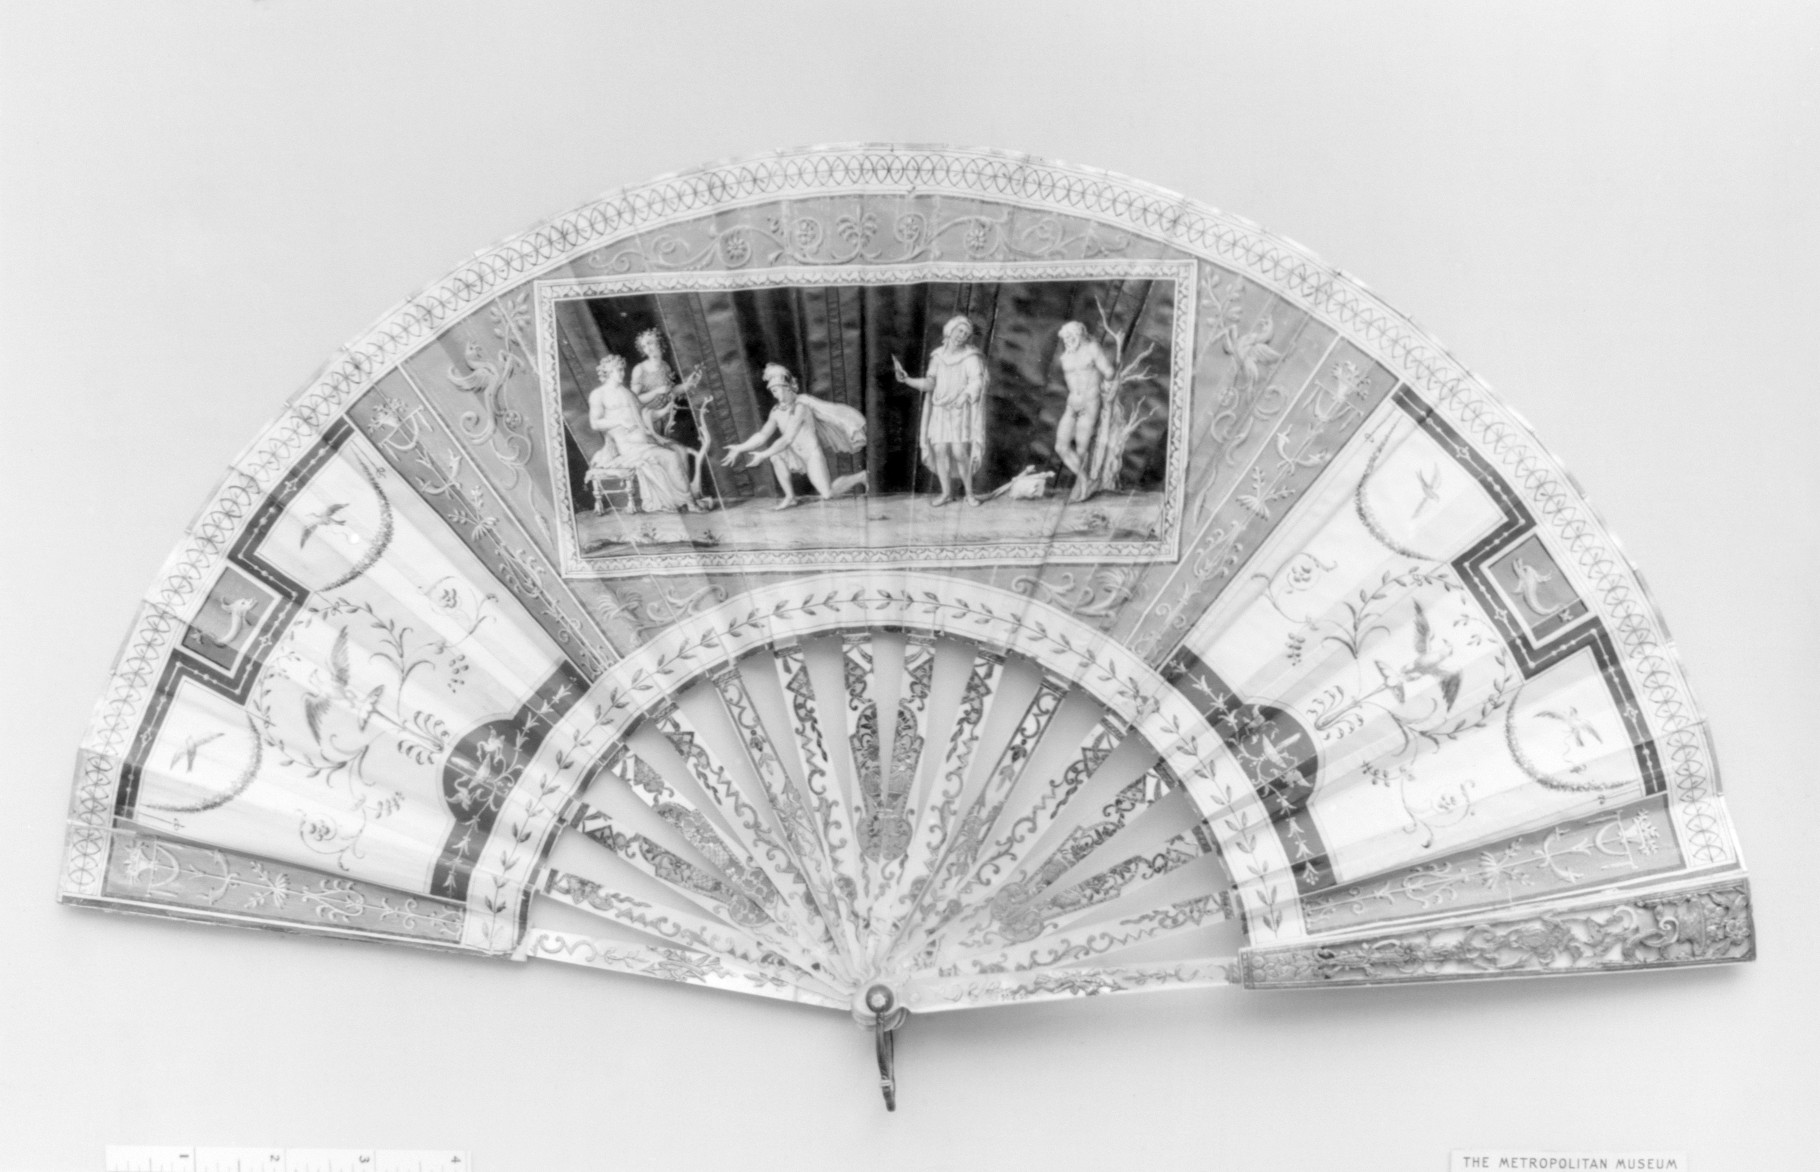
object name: fan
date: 1776-1800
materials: gold, mother of pearl, paint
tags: birds,men,male nudes,harps